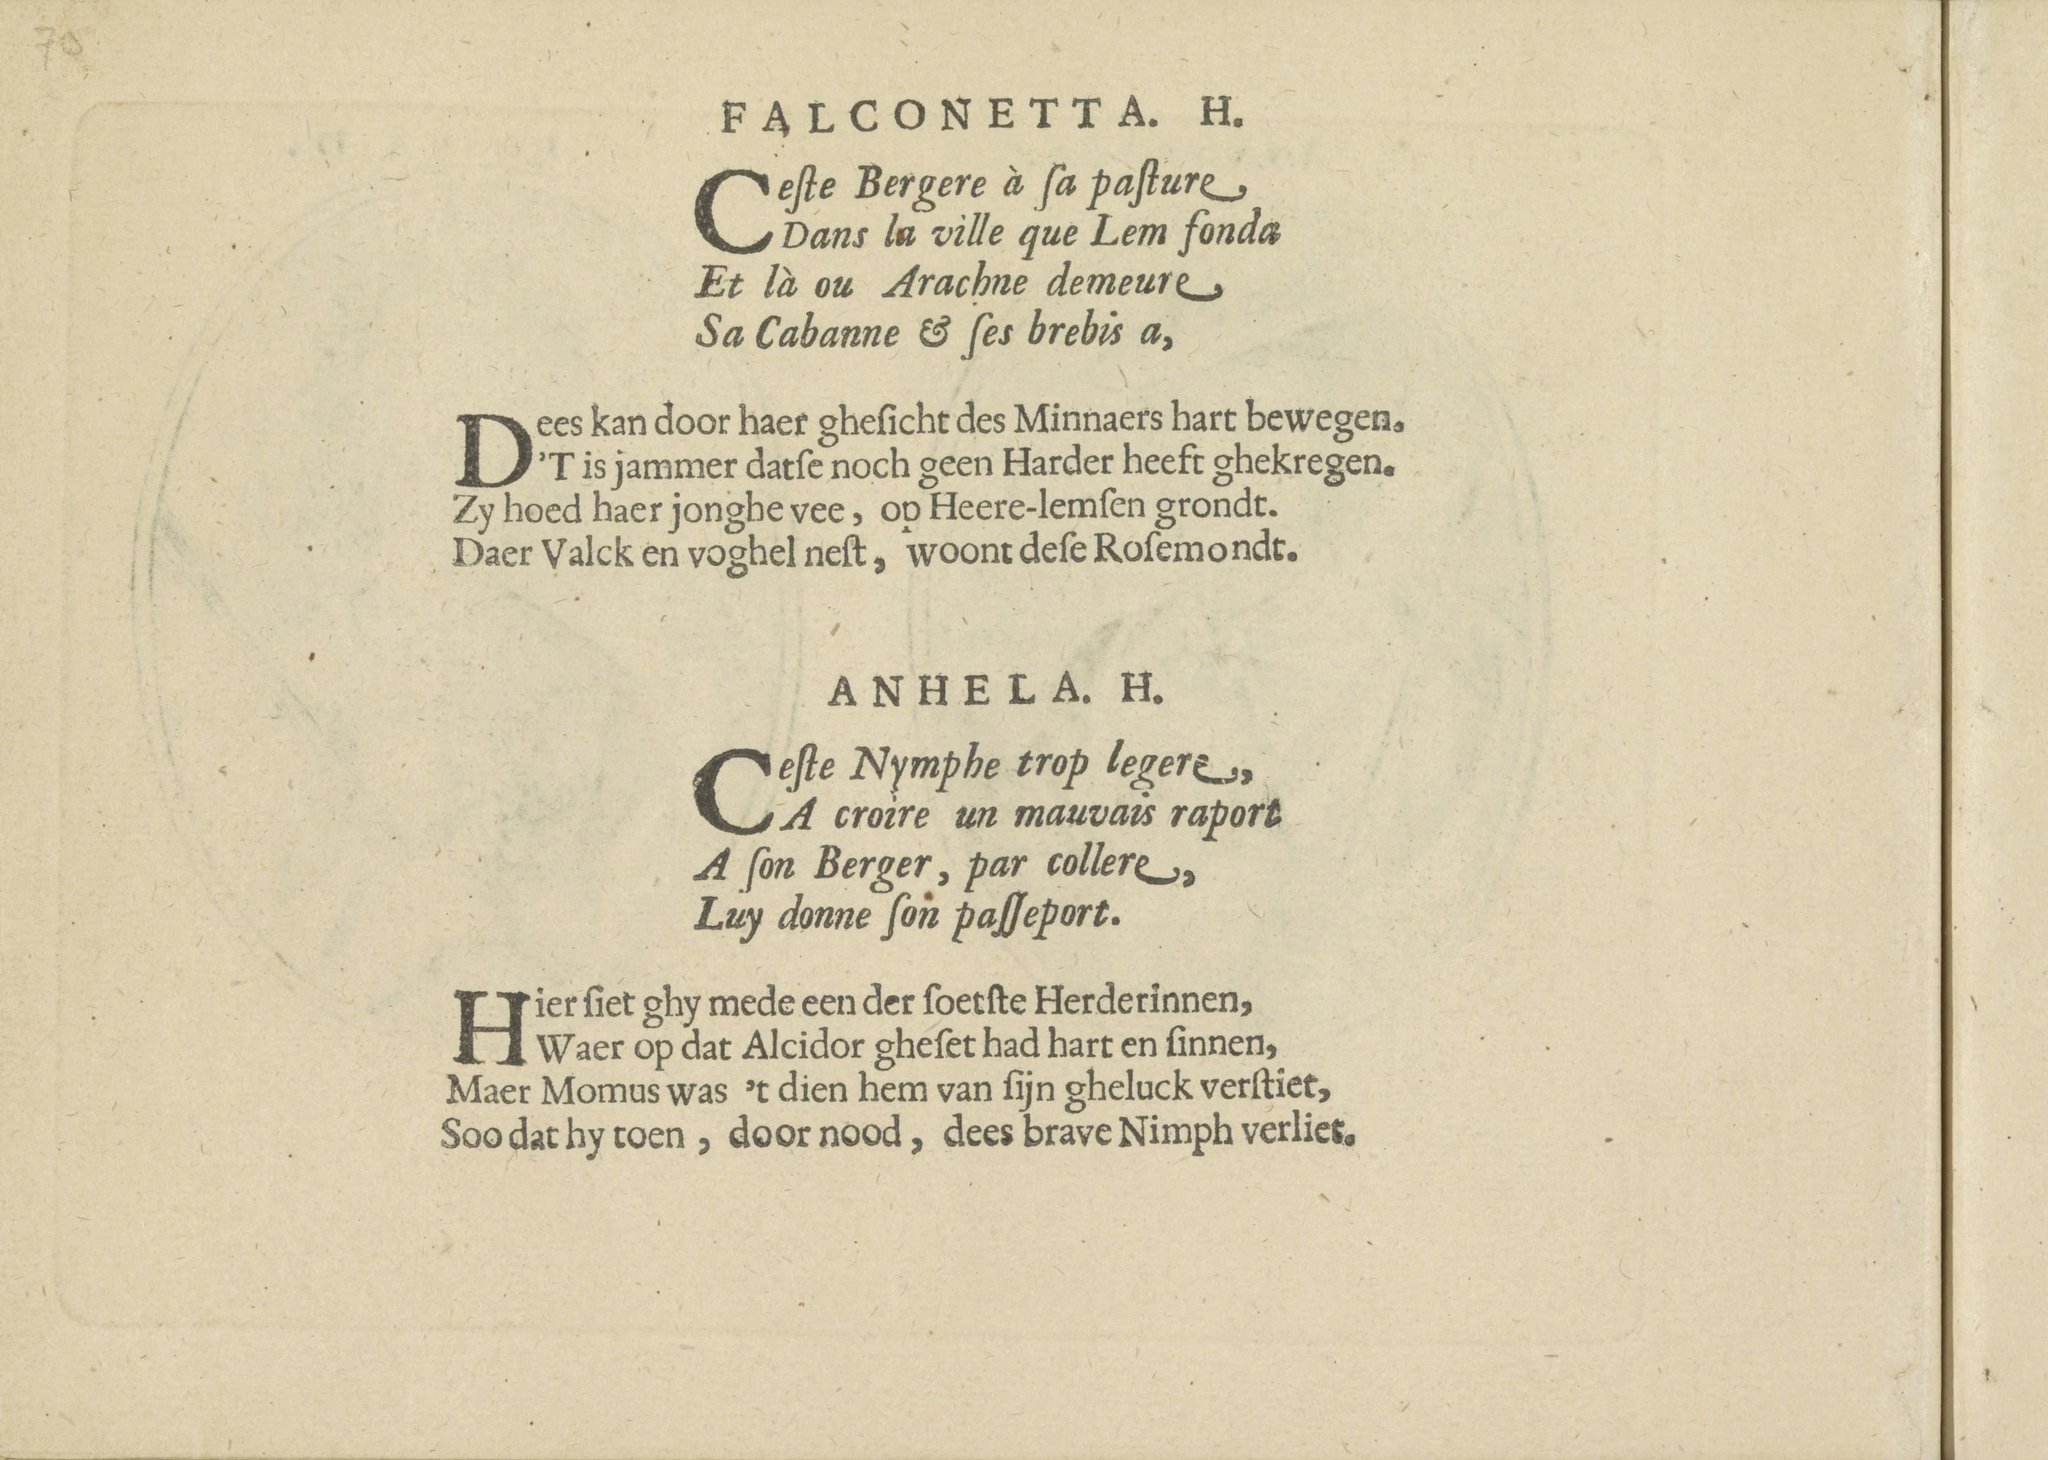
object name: album leaf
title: Kwatrijnen bij de voorstellingen van Falconetta A.H. en Anhela H.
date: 1640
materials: paper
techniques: letterpress printing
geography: amsterdam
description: Twee keer twee kwatrijnen in het Frans en Nederlands bij de voorstellingen van Falconetta A.H. en Anhela H. Het blad maakt deel uit van een album.